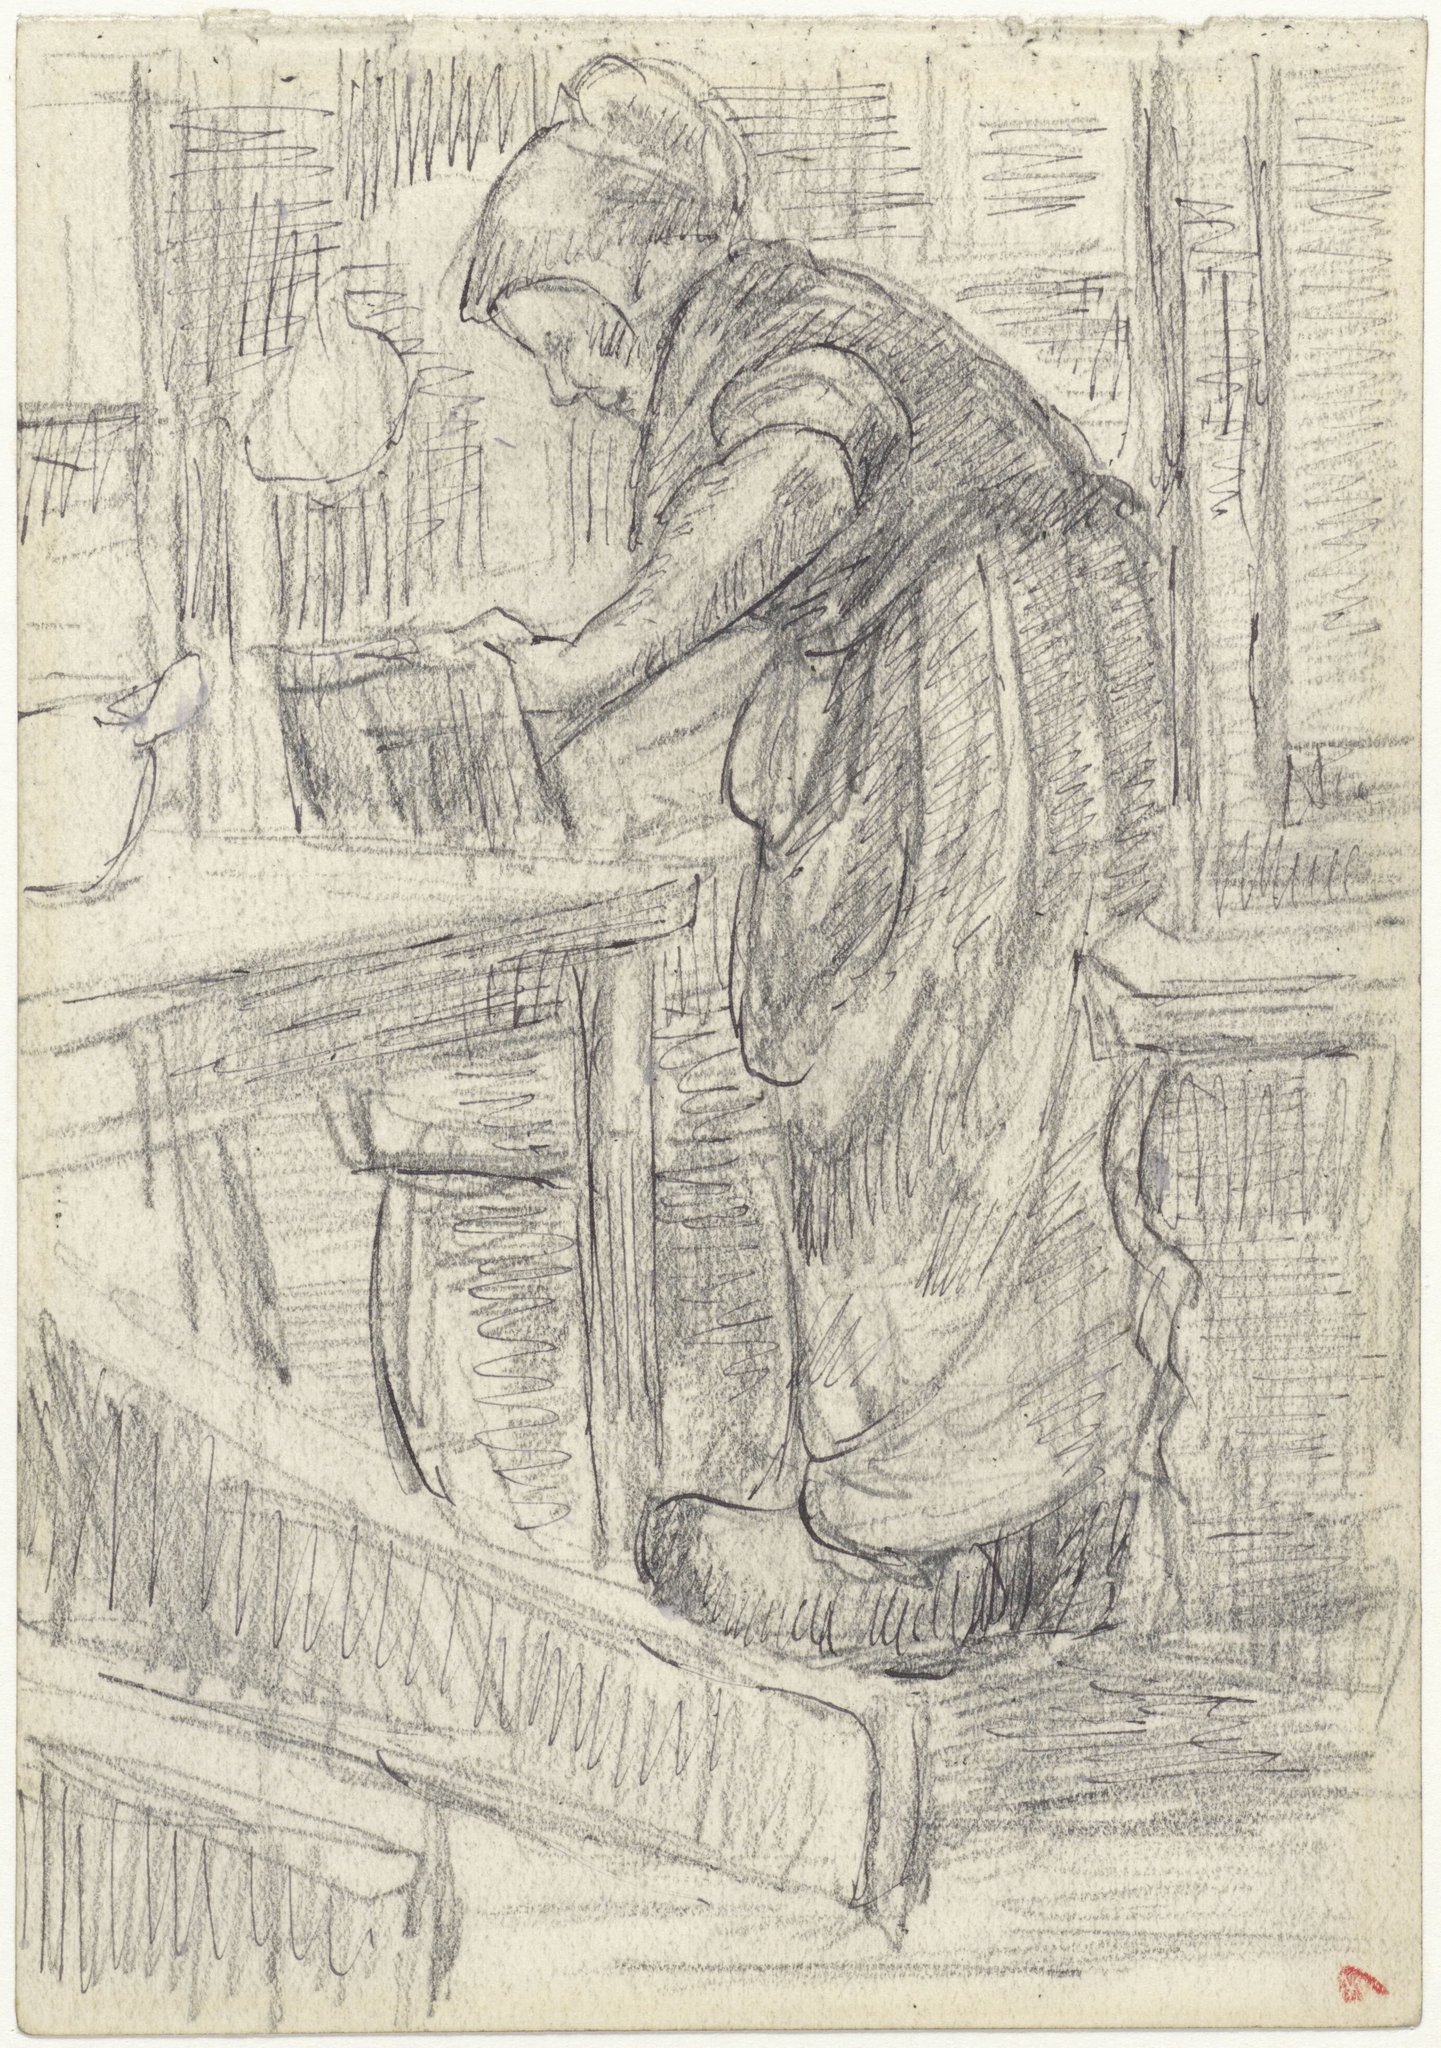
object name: drawing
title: Staande boerin in een keuken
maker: jozef israëls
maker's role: draughtsman, painter, print maker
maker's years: 1824-1911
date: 1834-1911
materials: ink, paper, pencil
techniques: pen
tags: kitchen-interior